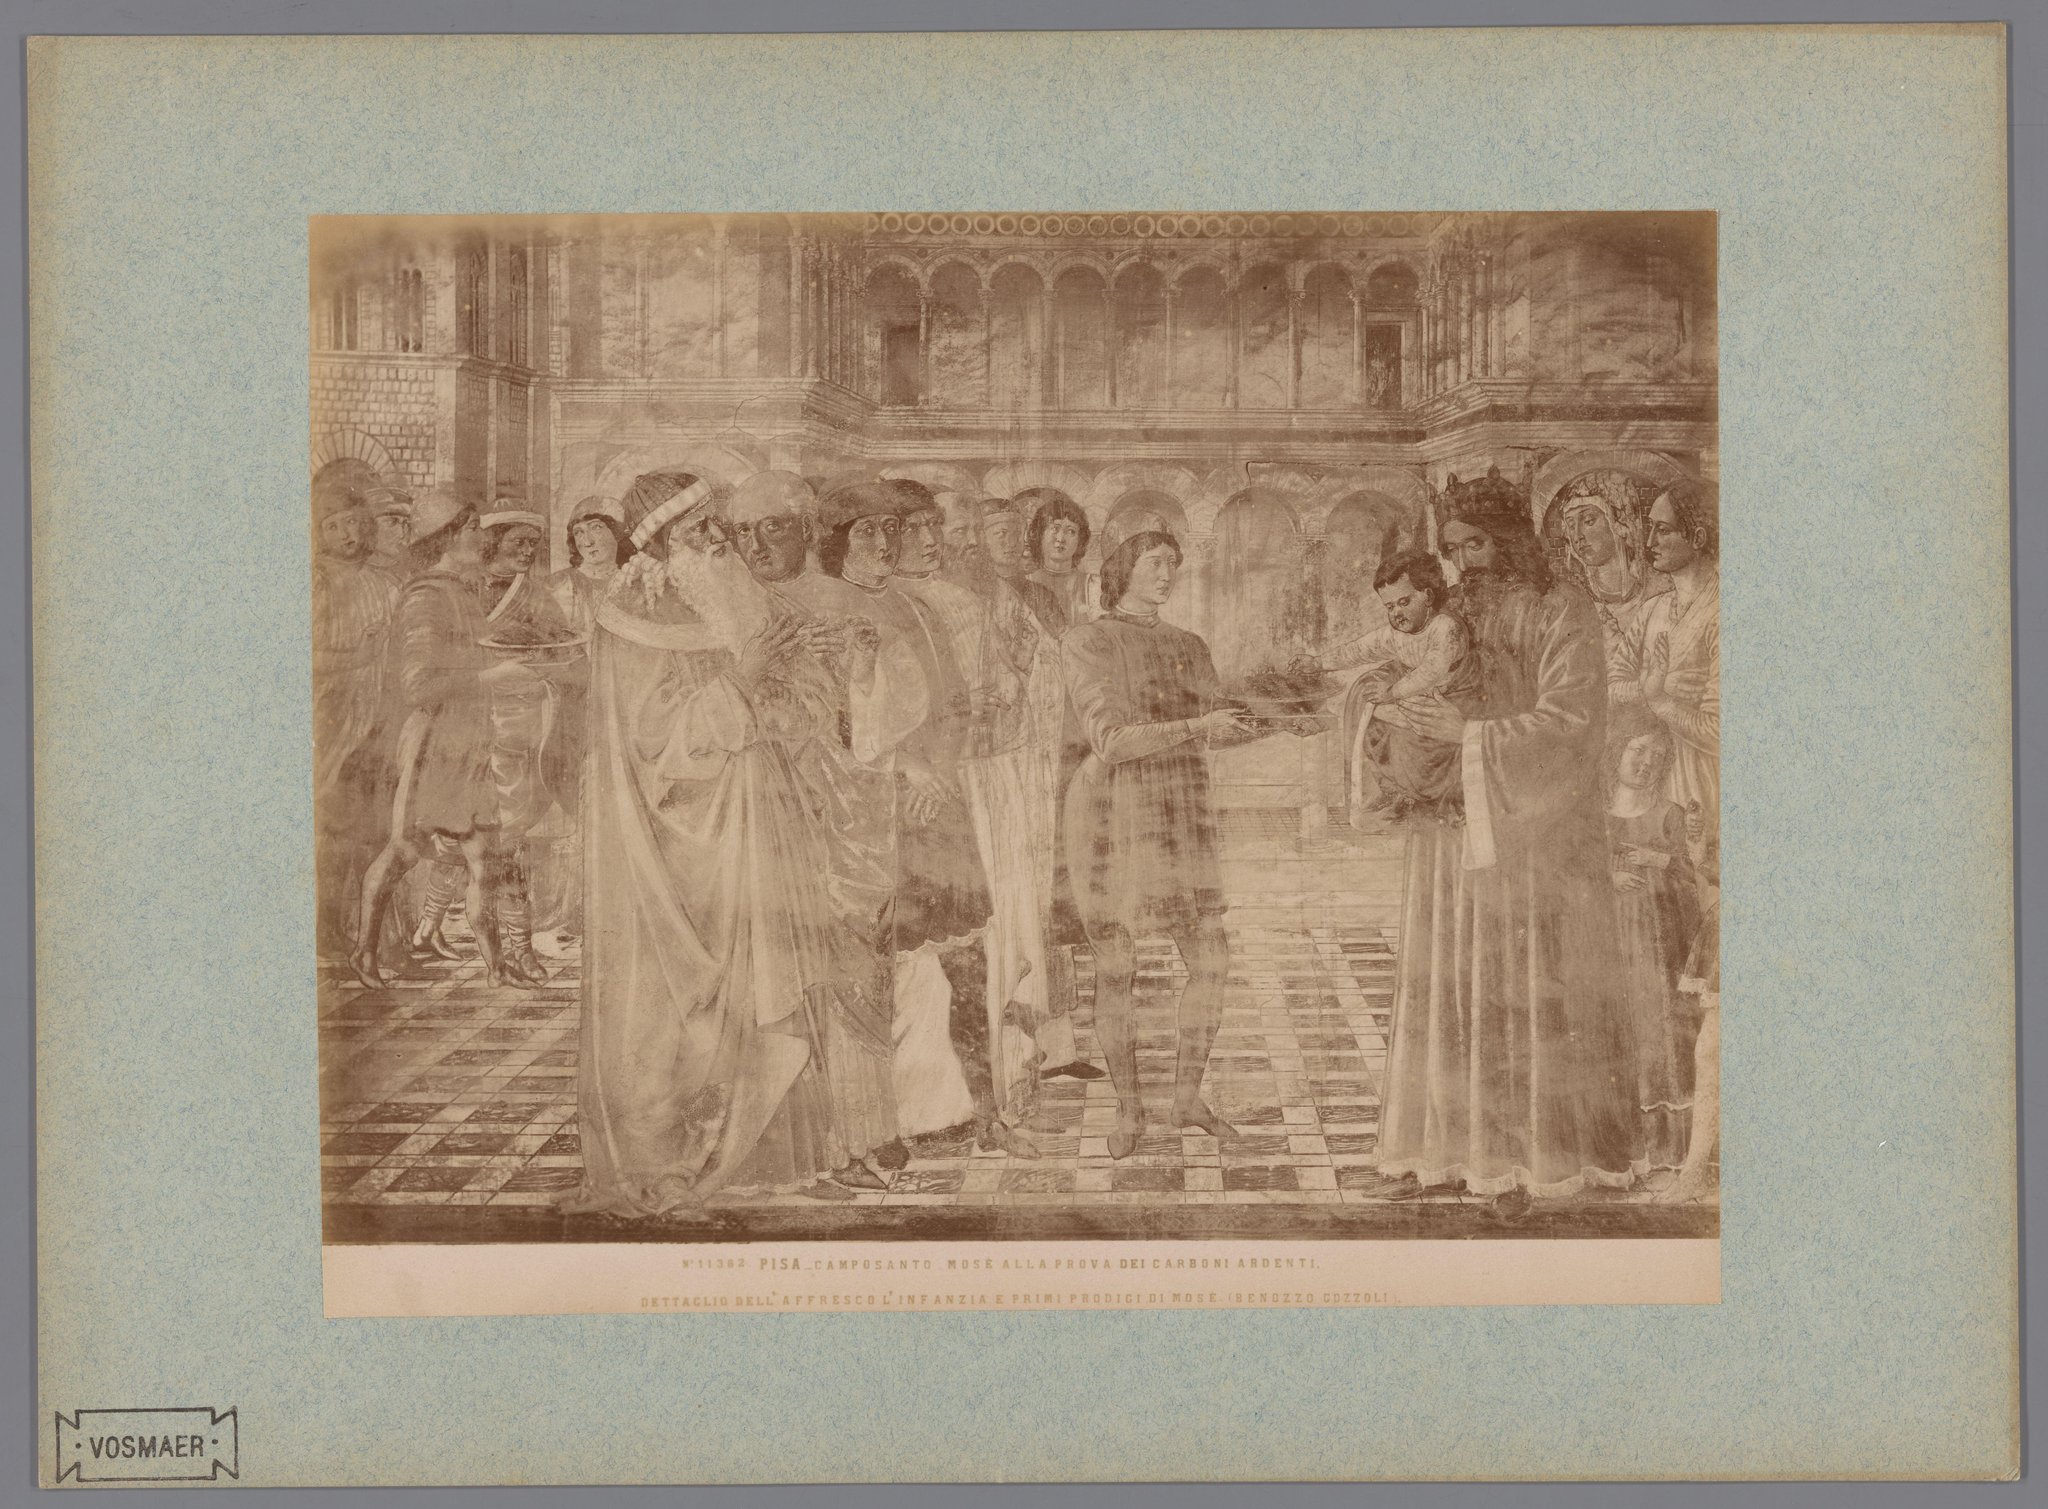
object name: reproduction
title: Fotoreproductie van een detail van het fresco Jeugd en eerste wonderen van Mozes naar Benozzo Gozzoli in het Camposanto te Pisa, Italië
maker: benozzo gozzoli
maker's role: draughtsman, painter, sculptor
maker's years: 1421-1497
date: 1857-1900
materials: cardboard, paper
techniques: albumen print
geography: pisa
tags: picture, painting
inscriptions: collector's mark: ‘VOSMAER’, number: ‘No. 11382’